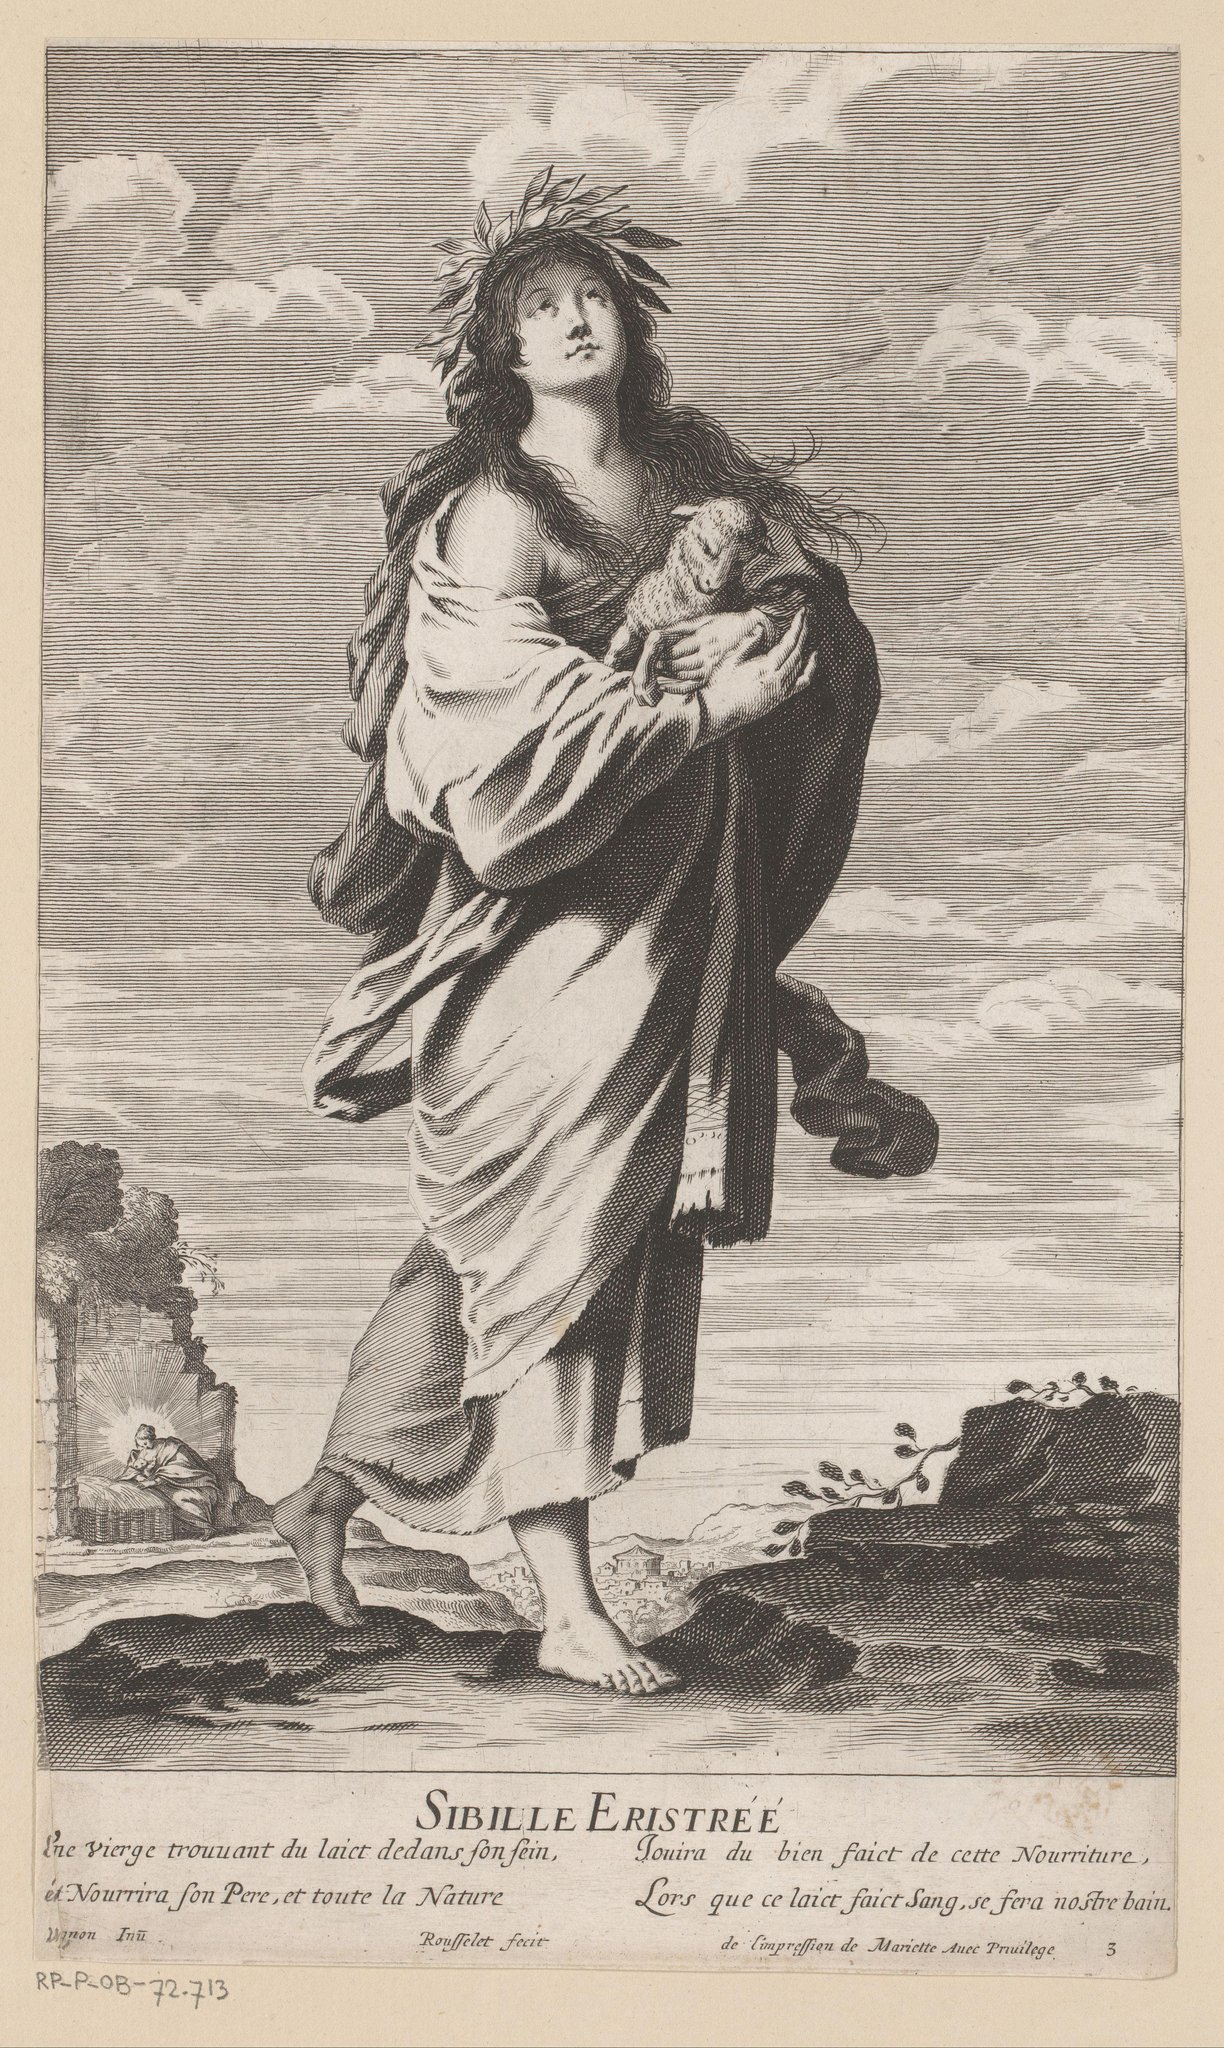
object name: print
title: Sibille Eristréé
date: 1635-1640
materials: paper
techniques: engraving, etching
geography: france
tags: madonna: i.e. mary with the christ-child, erythraean sibyl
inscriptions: collector's mark: Lugt 240